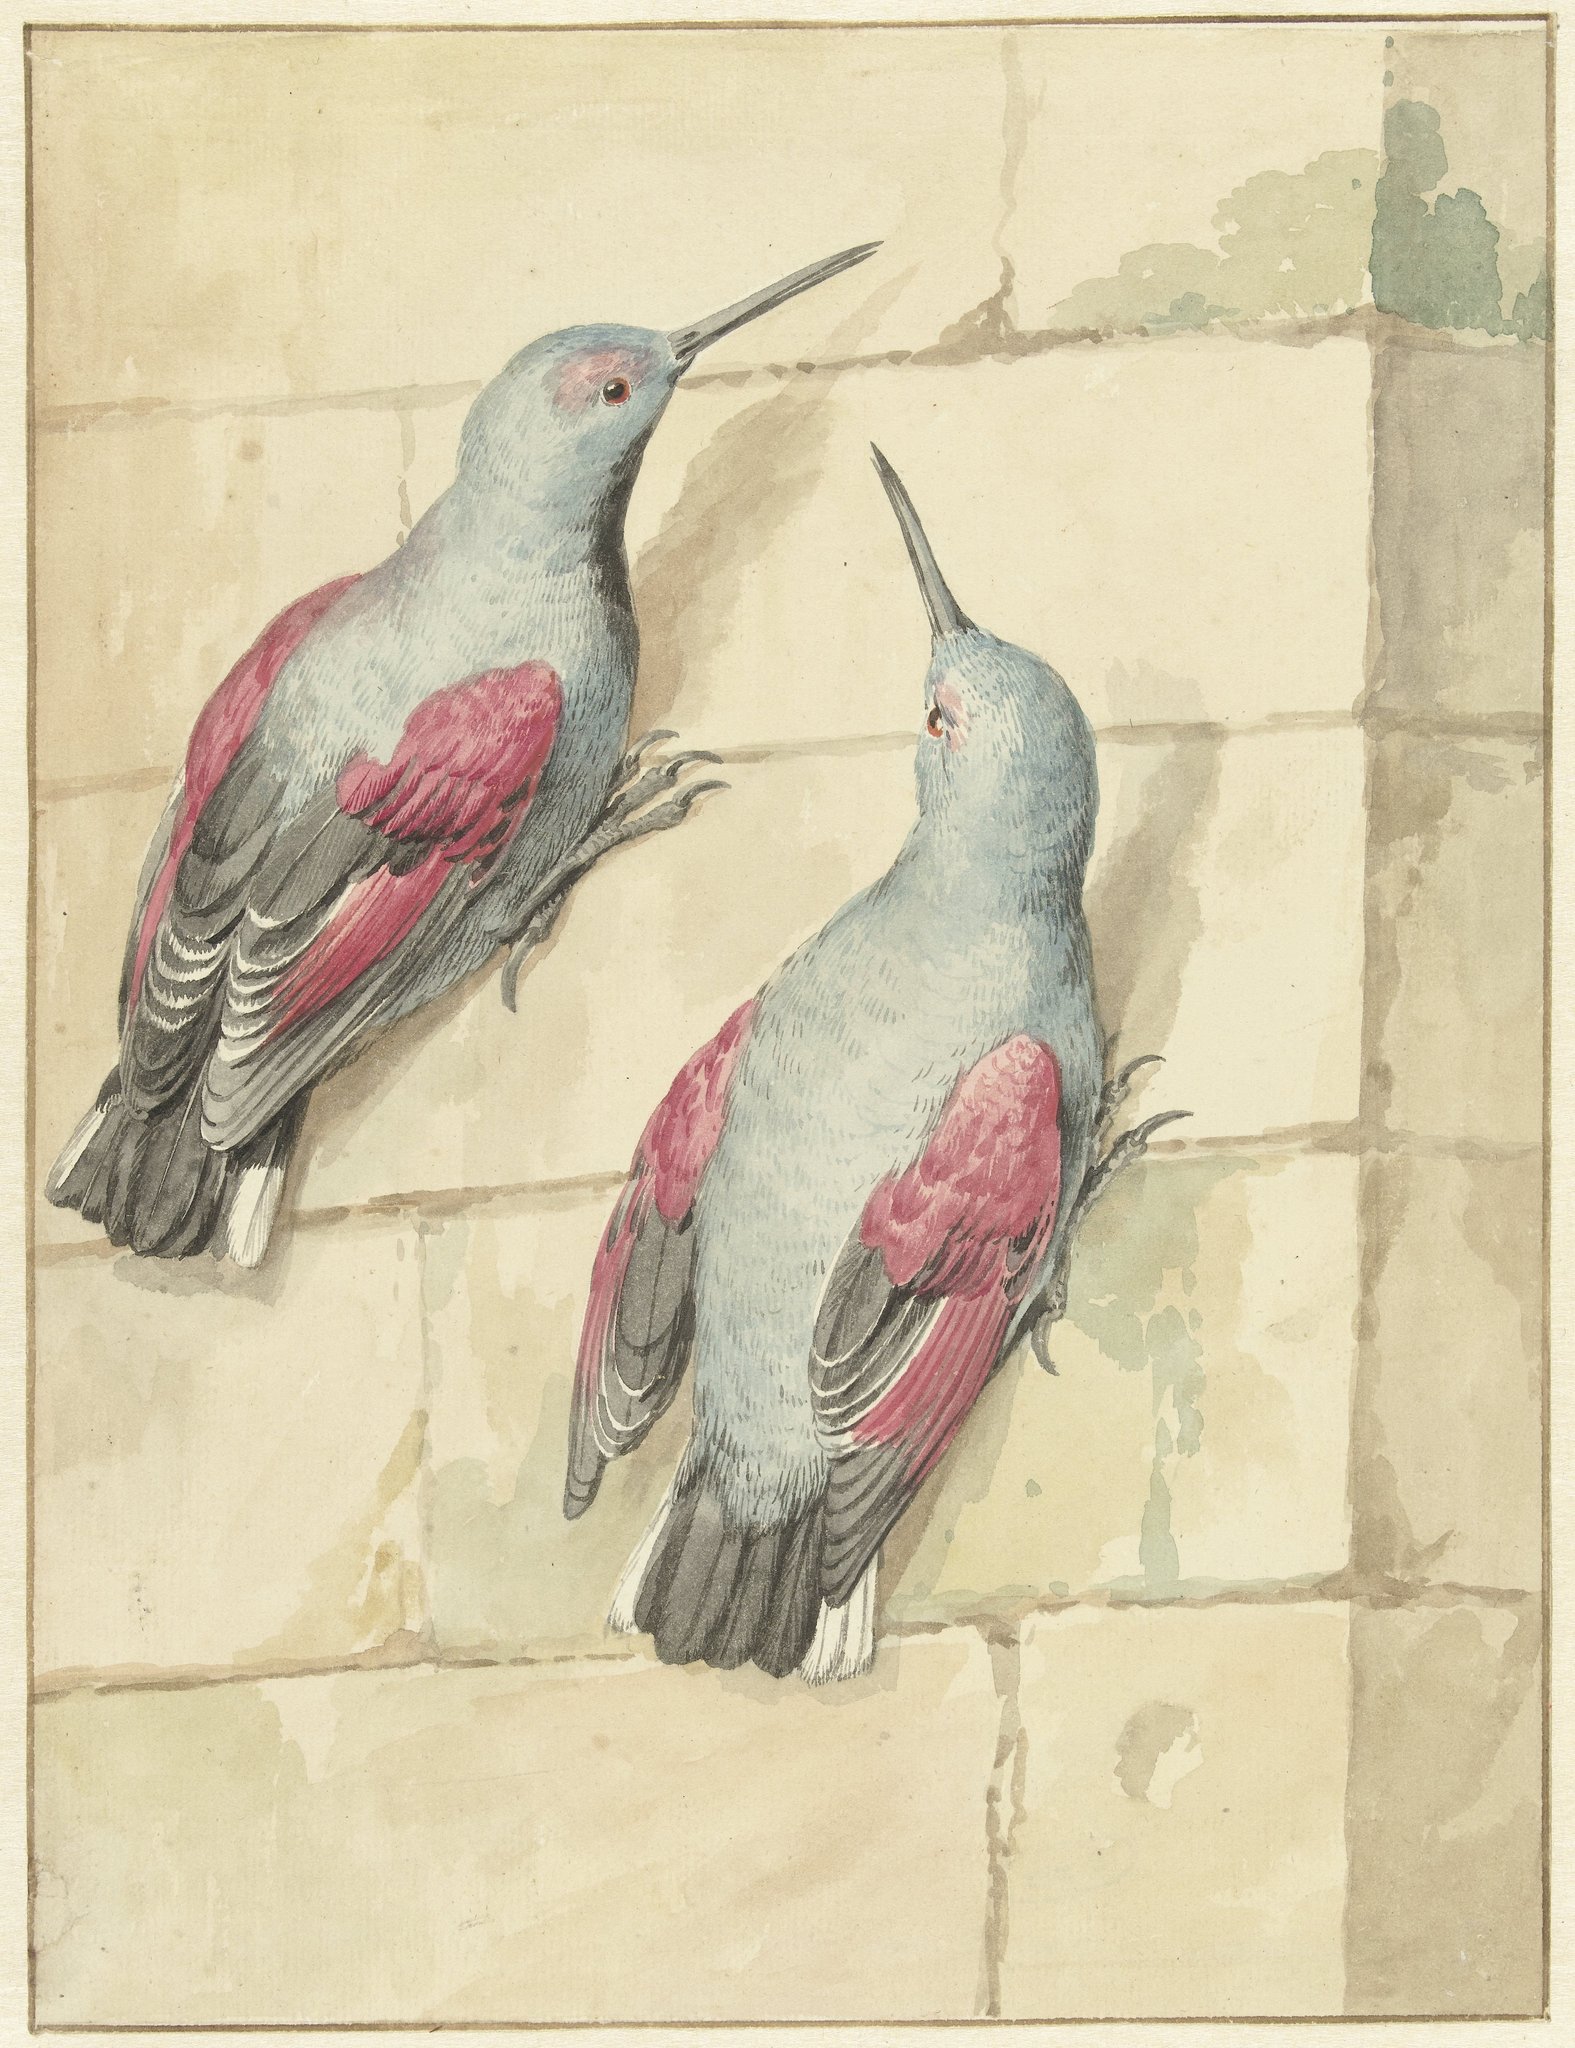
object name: drawing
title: Twee rotskruipers, blauw en paars, op een muur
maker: aert schouman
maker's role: draughtsman, painter, print maker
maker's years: 1710-1792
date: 1720-1792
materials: paper, watercolor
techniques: brush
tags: other birds: wall creeper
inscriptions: inscription: ‘Grunpereau de muraille male et sa femelle’